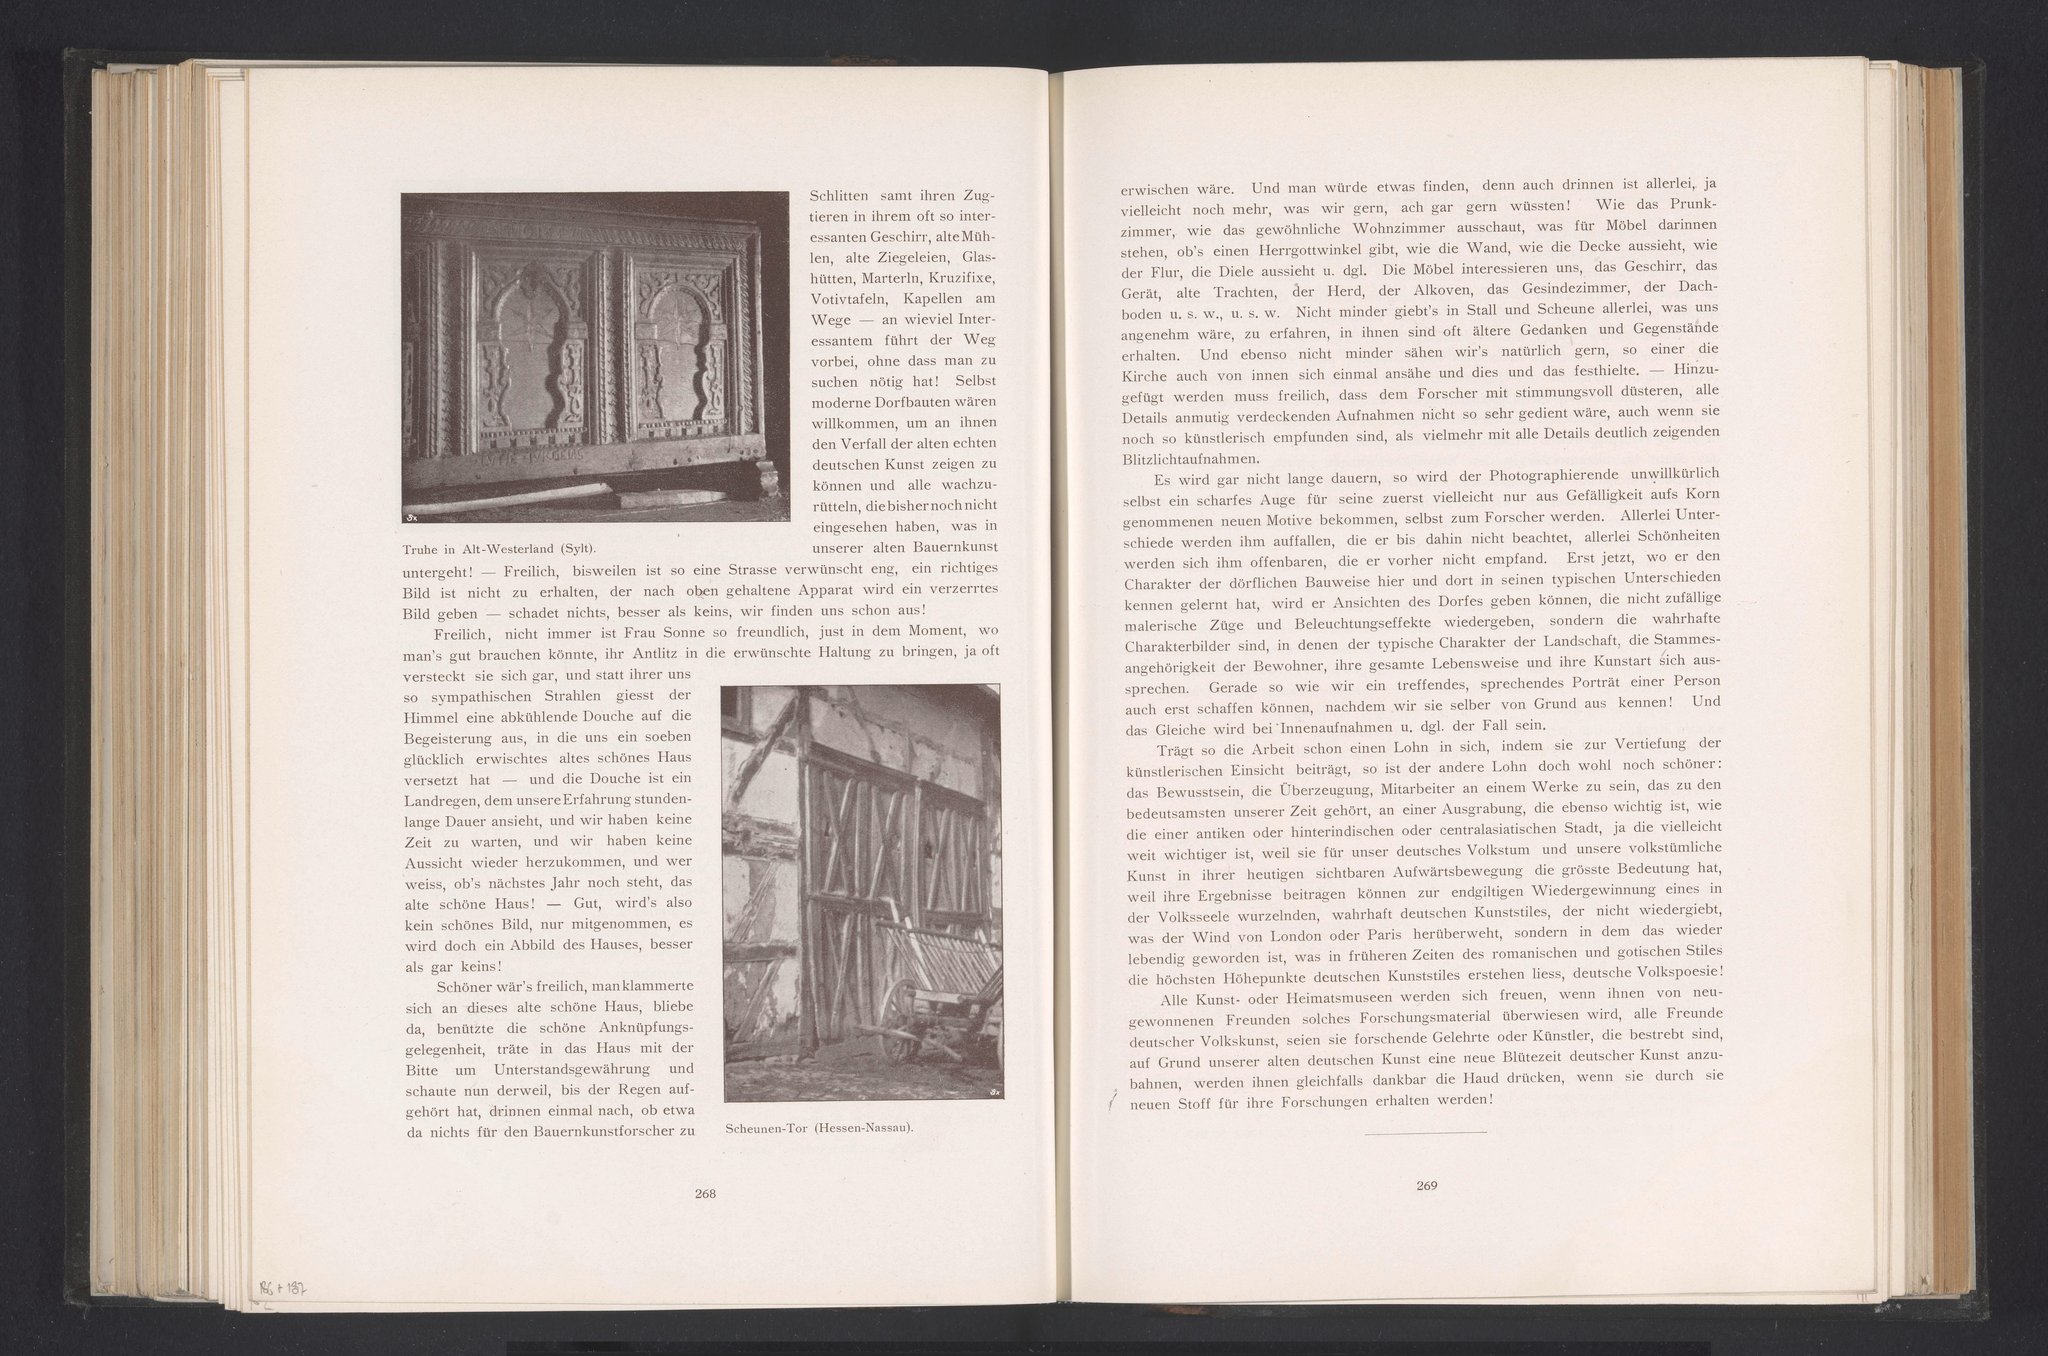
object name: photomechanical print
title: Poort van een schuur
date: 1898-1903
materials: paper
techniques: autotype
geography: hessen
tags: gate, entrance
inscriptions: monogram: ‘BX’